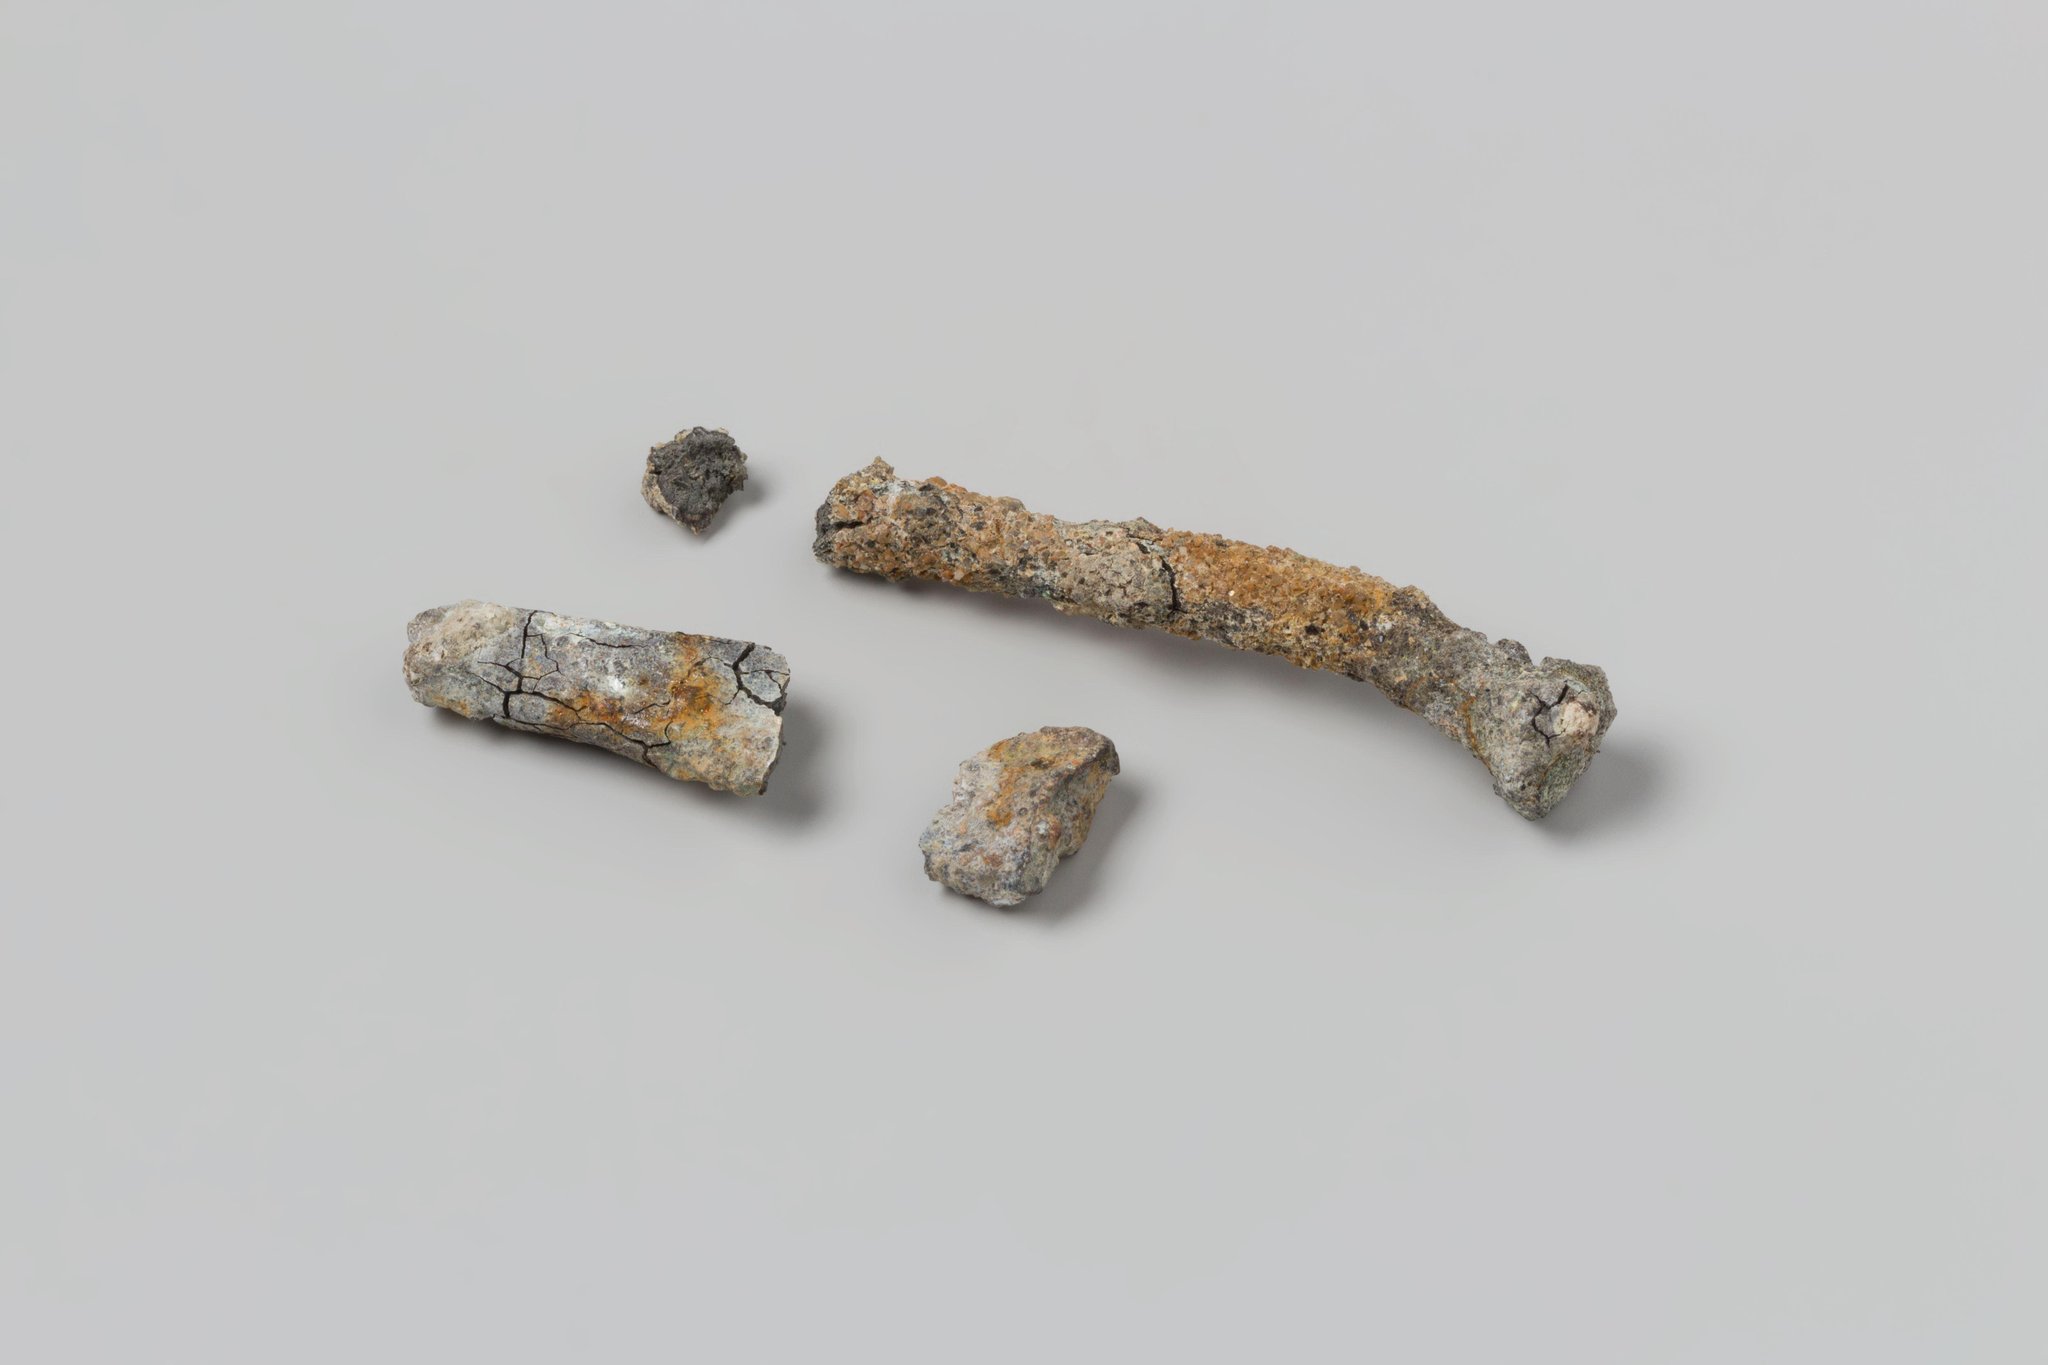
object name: fork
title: Fragmenten stelen van vorken of lepels uit het wrak van de Oost-Indiëvaarder Hollandia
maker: Anonymous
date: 1700-1743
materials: tin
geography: netherlands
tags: verenigde oostindische compagnie, hollandia (schip), annet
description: Cutlery, fragment: stem of fork or spoon; fragm, sim. NG 1980-27H49a.